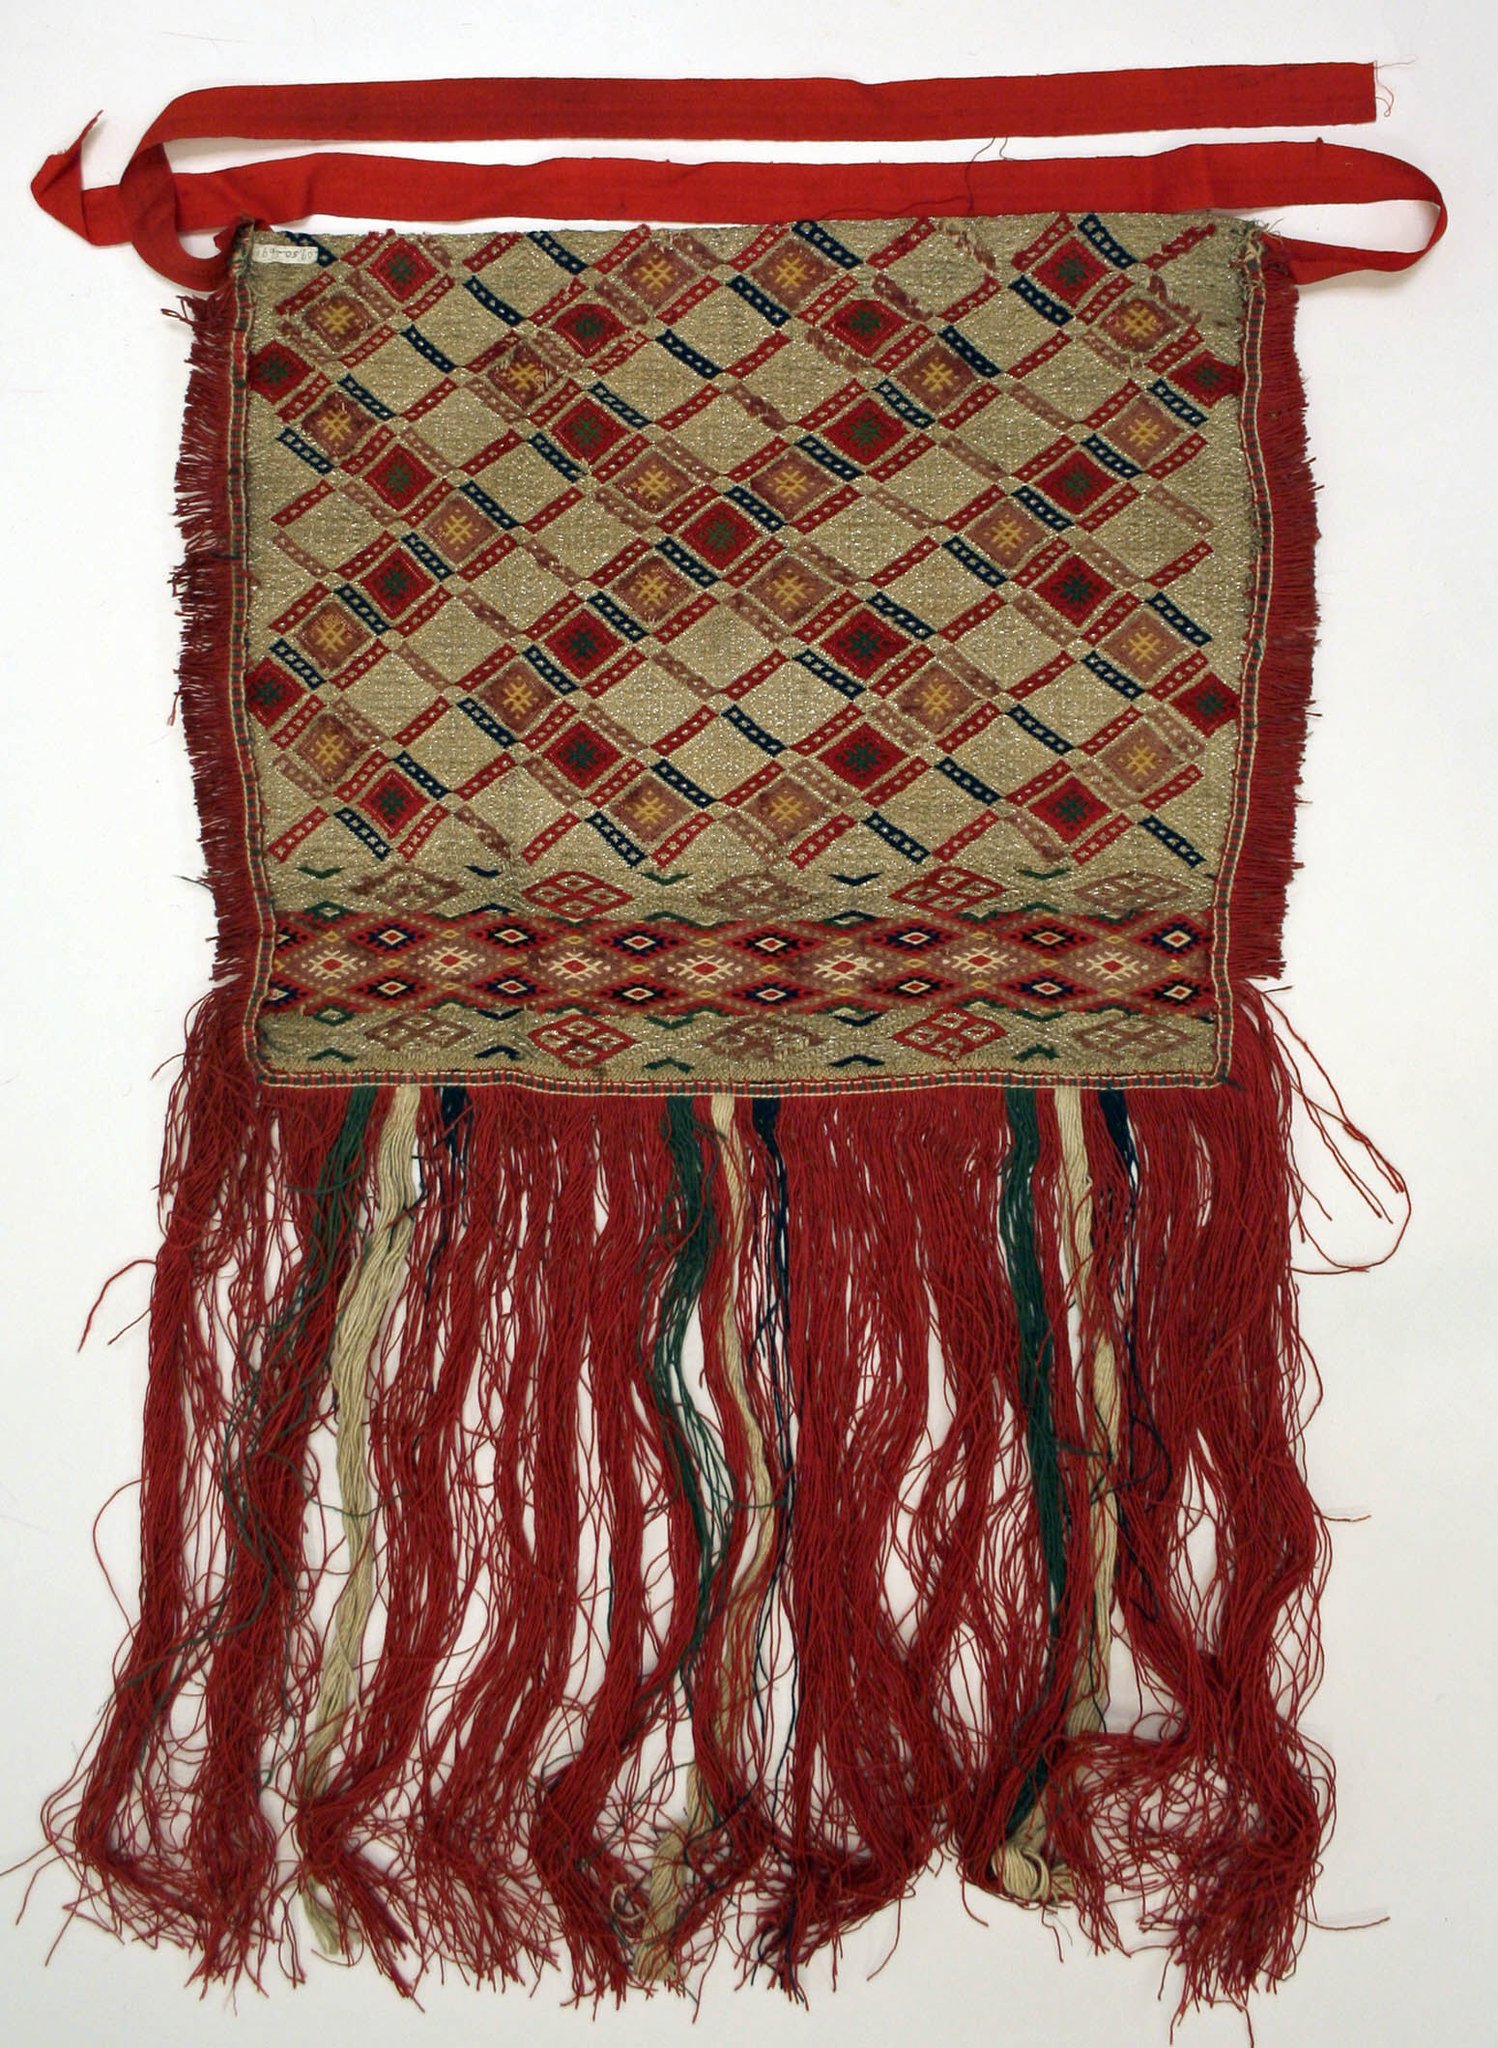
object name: apron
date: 1801-1900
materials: wool